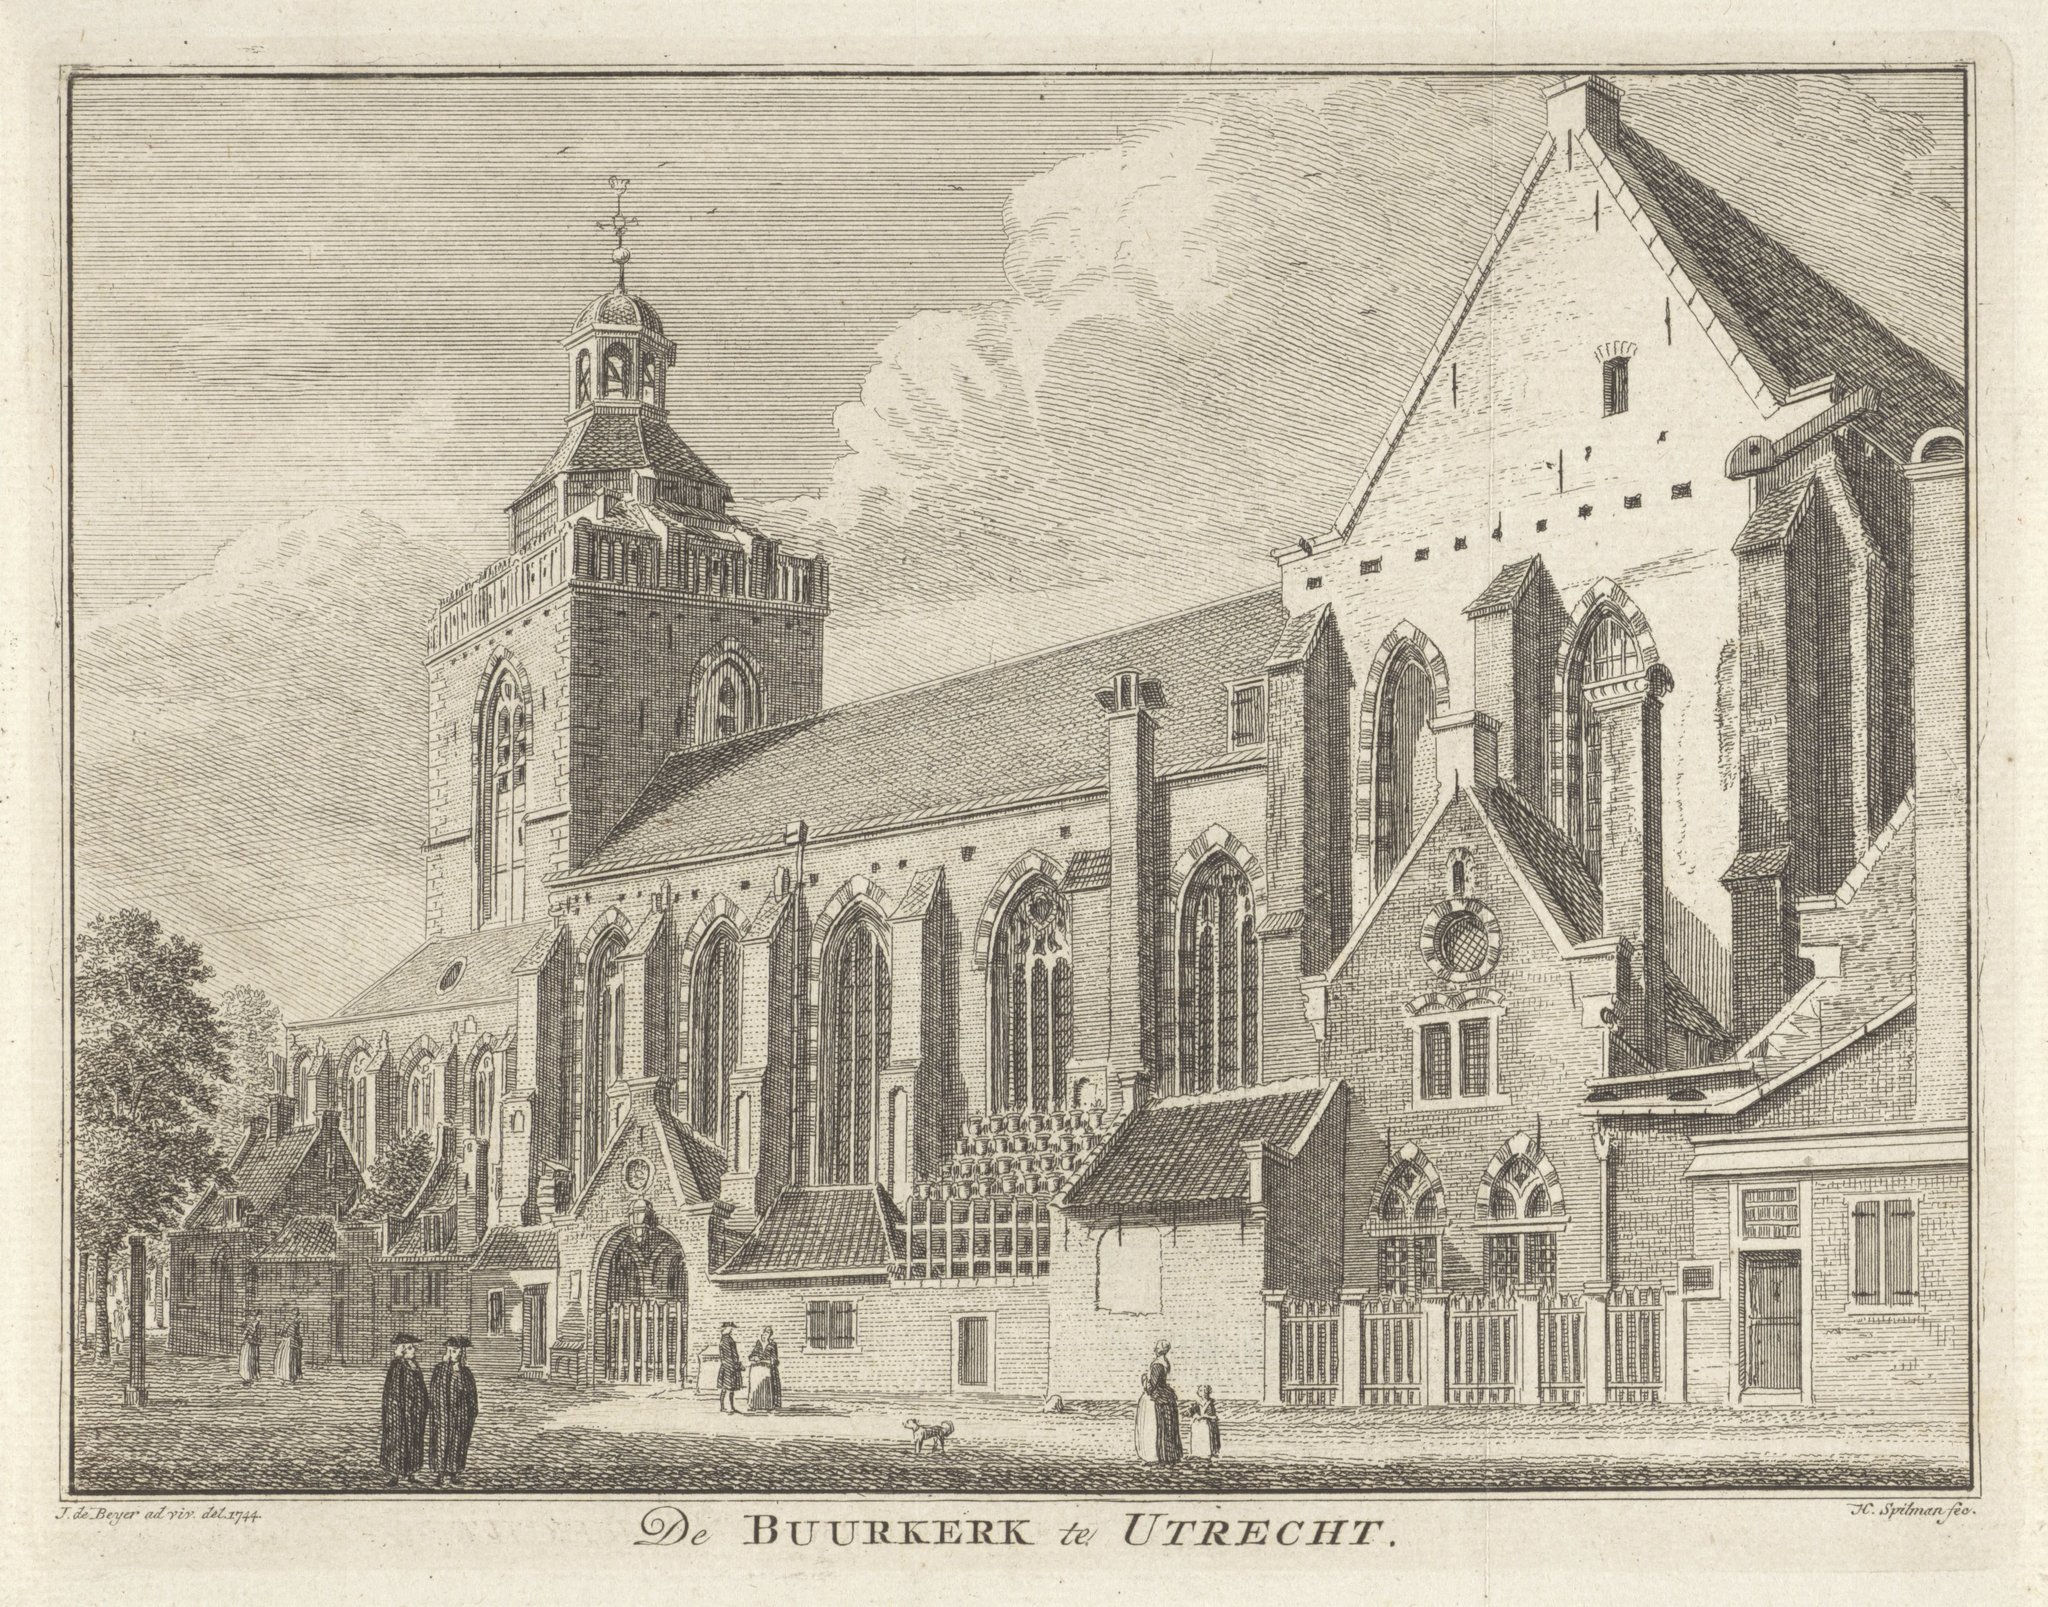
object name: print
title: Gezicht op de Buurkerk te Utrecht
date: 1744-1758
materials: paper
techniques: engraving, etching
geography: haarlem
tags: church (exterior)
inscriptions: collector's mark: Lugt 2228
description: Prent ook gebruikt in: Tegenwoordige staat der Vereenigde Nederlanden, elfde deel, behelzende eene beschryving van de provincie van Utrecht. Met landkaarten, plans der steden en printverbeeldingen versierd / Hedendaagsche historie, of tegenwoordige staat van alle volkeren; XXI. deel (…). Amsterdam: Isaak Tirion, 1758, tussen p. 374 en p. 375.